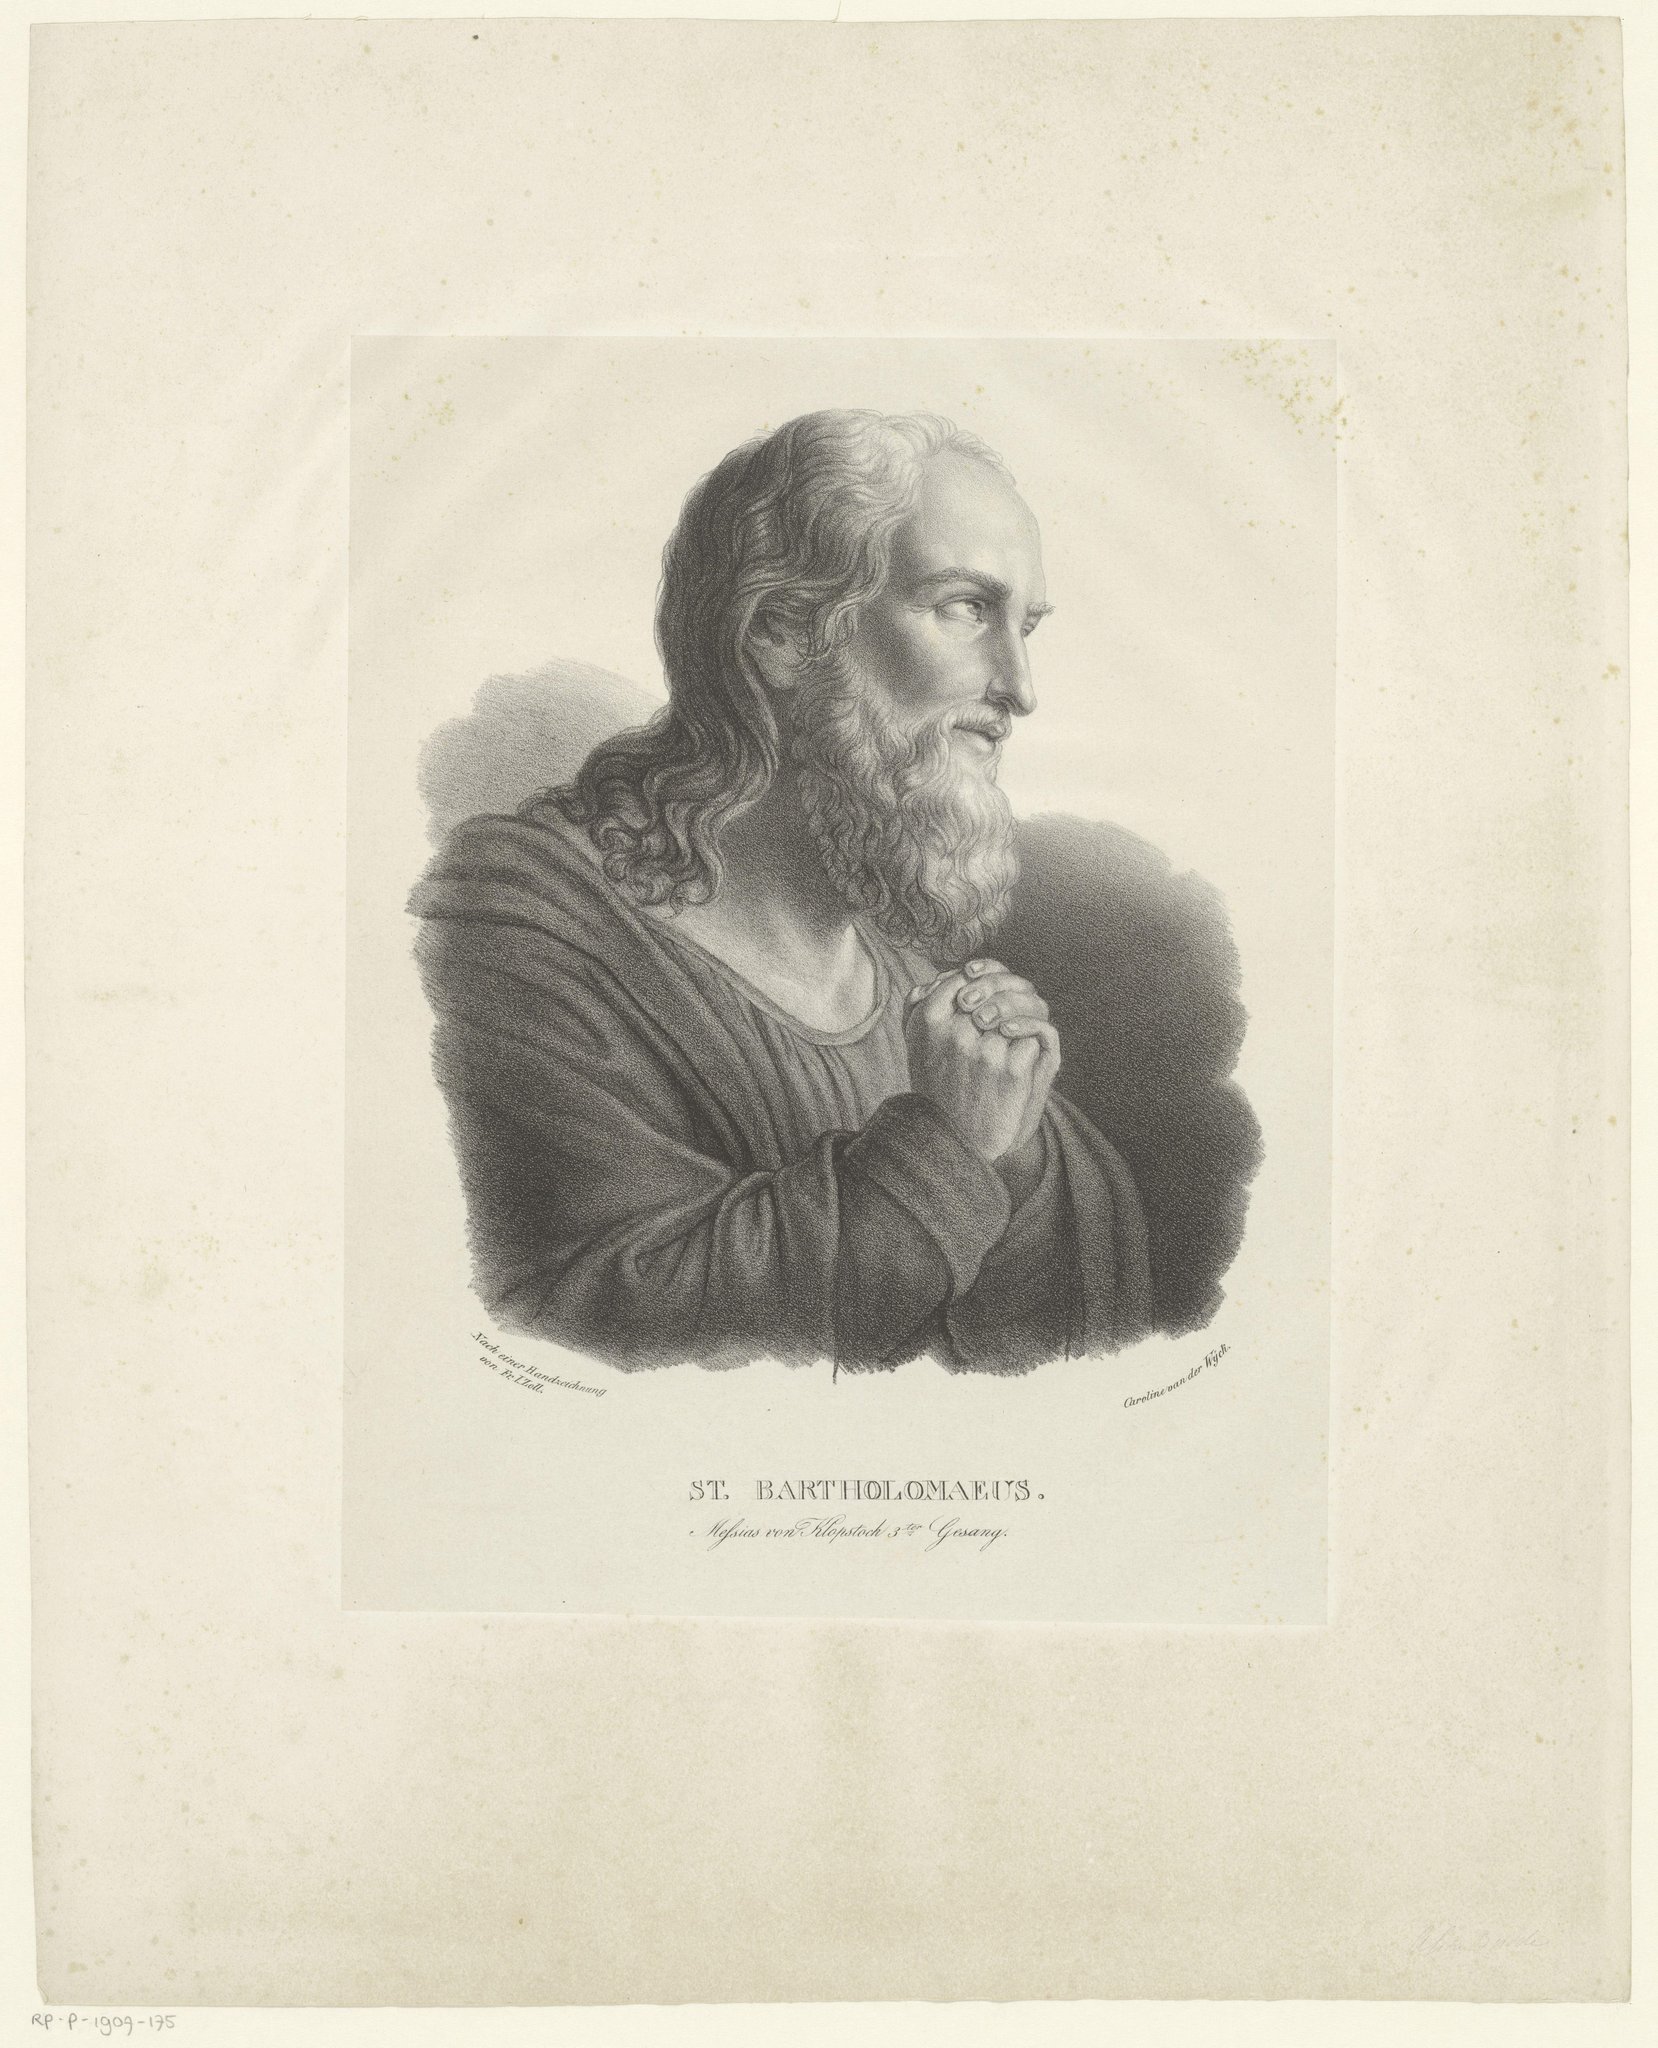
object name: print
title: Biddende heilige Bartholomeus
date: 1809-1869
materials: paper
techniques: lithograph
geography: the hague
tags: the apostle bartholomew; possible attributes: book, devil or dragon at feet, knife, scroll, flayed skin, staff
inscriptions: collector's mark: Lugt 2228